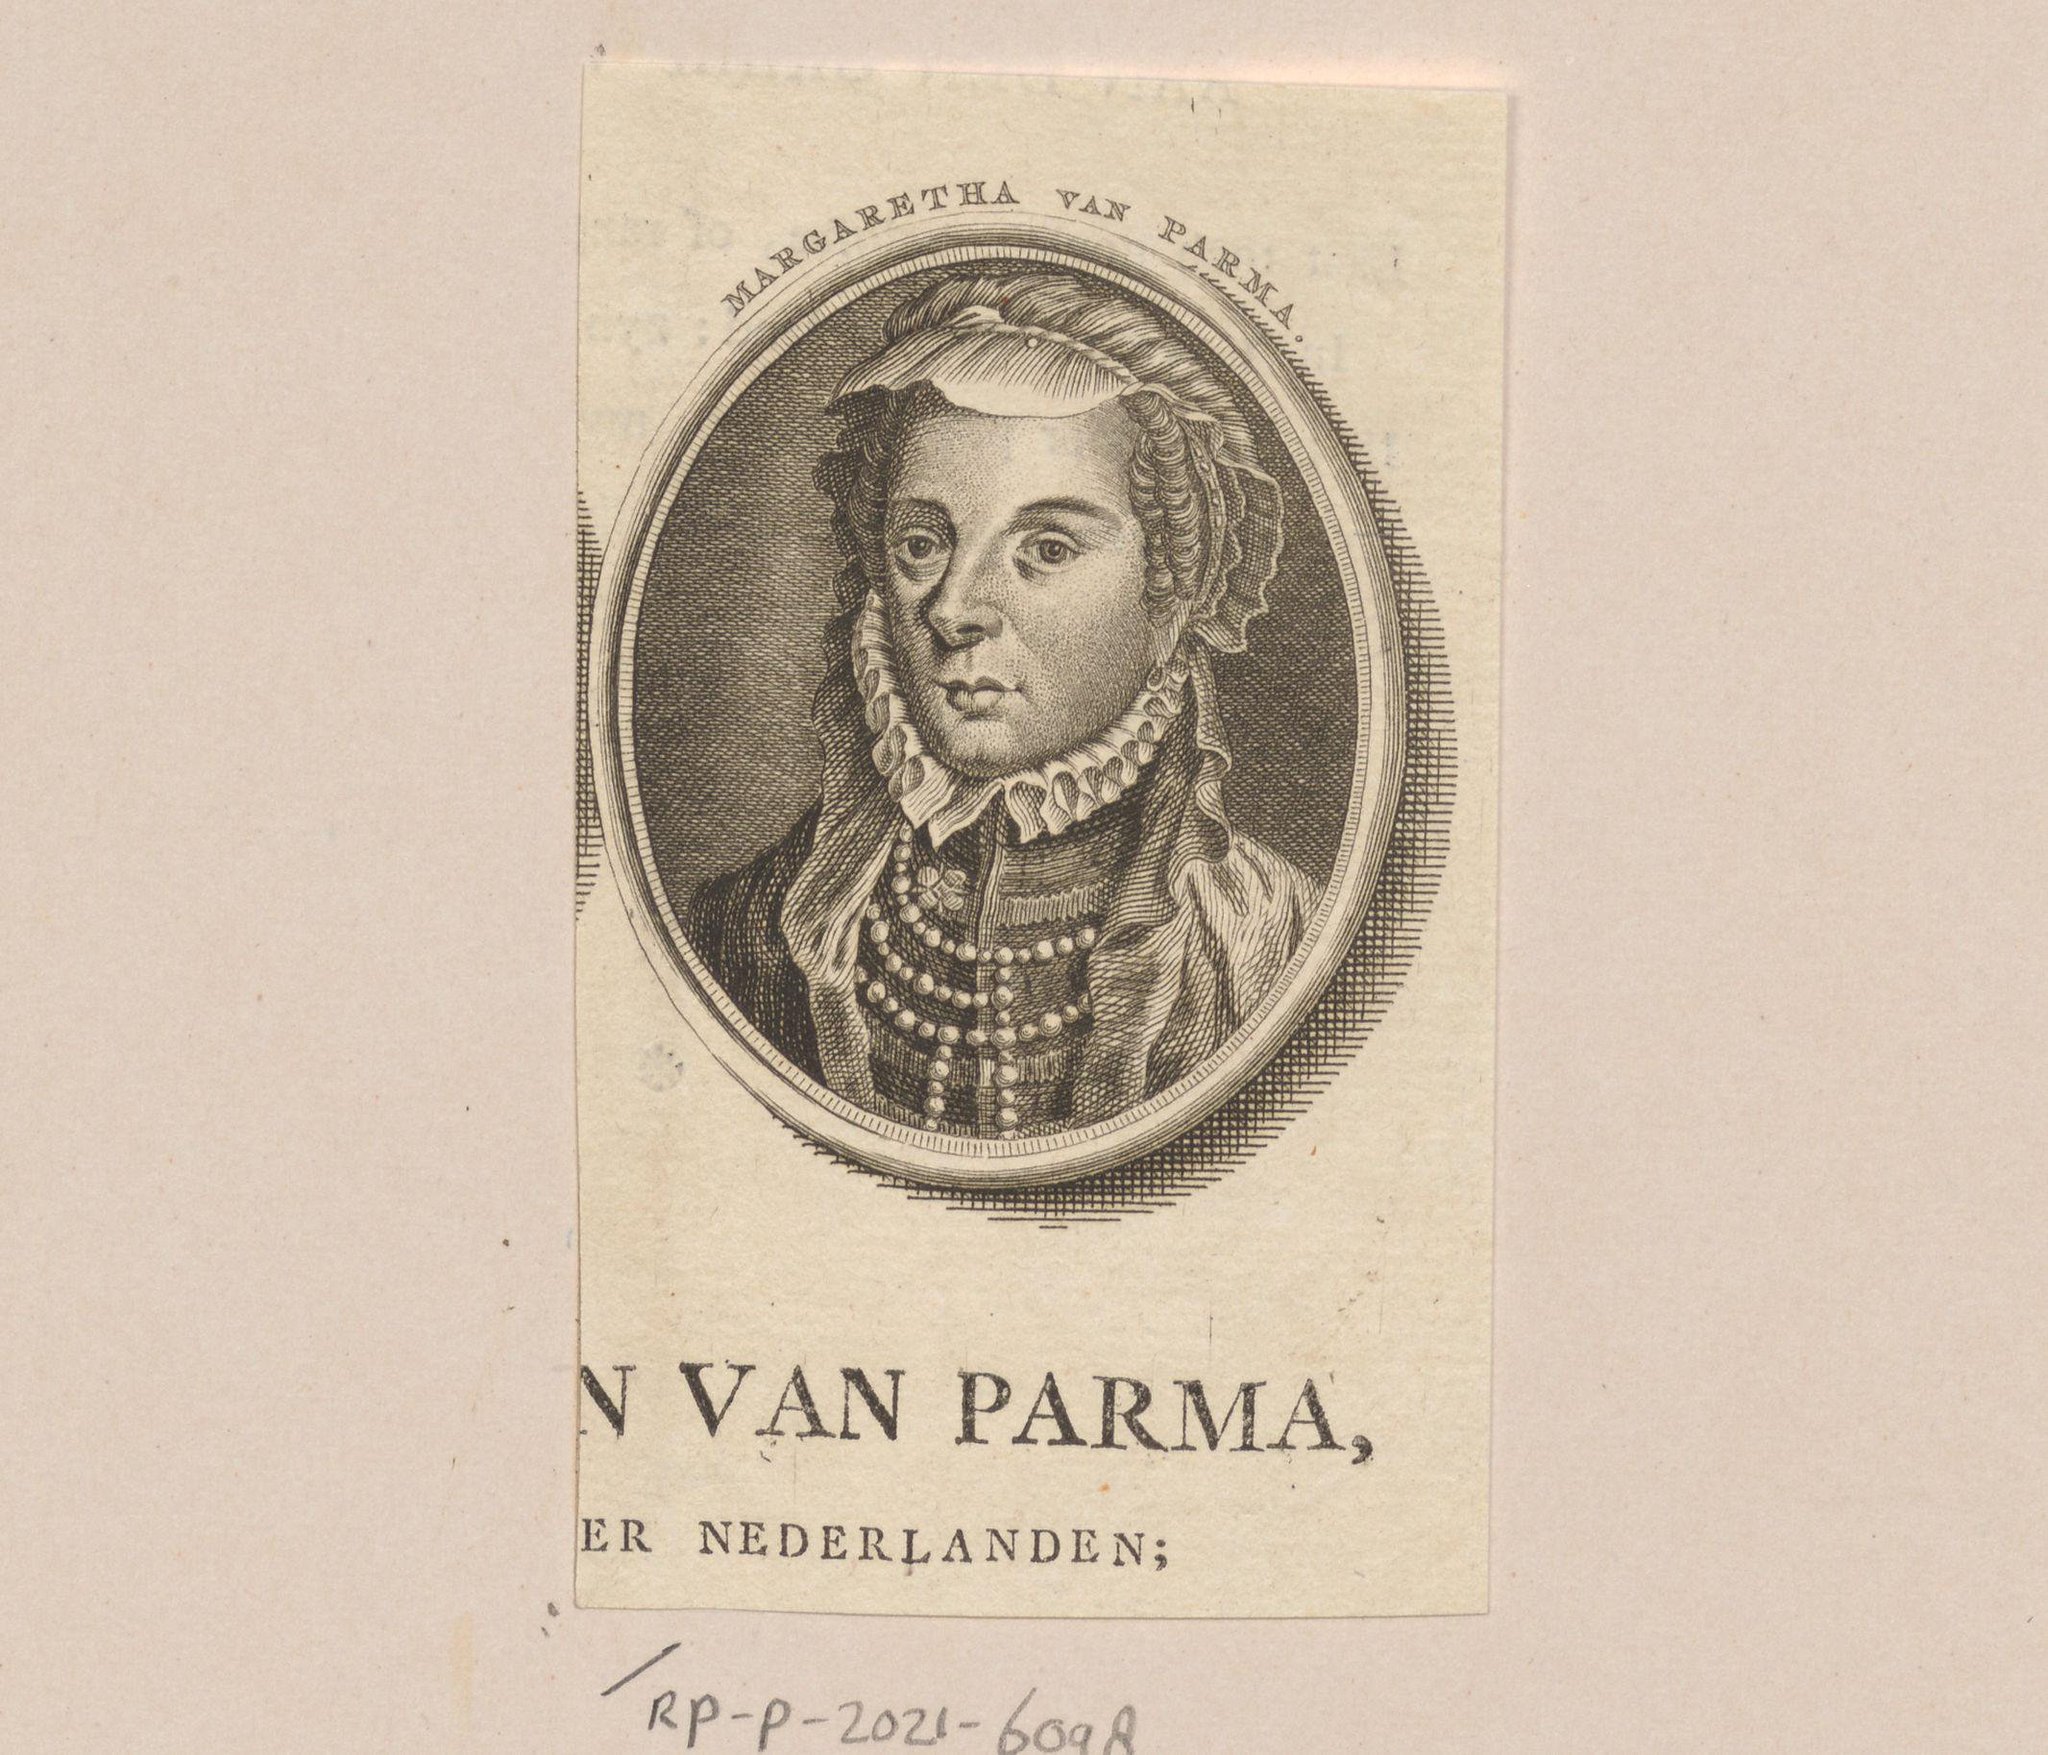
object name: book illustration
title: Portret van Margaretha van Parma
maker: Anonymous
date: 1785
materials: paper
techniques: engraving, etching, letterpress printing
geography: northern netherlands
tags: historical persons - bb - woman, ornament ~ medallion, regent, substitute ruler; viceroy - bb - female ruler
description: Prent waarschijnlijk uit: Nomsz, Johannes. Vaderlandsche brieven. Amsterdam: Willem Holtrop, 1785, p. 44.